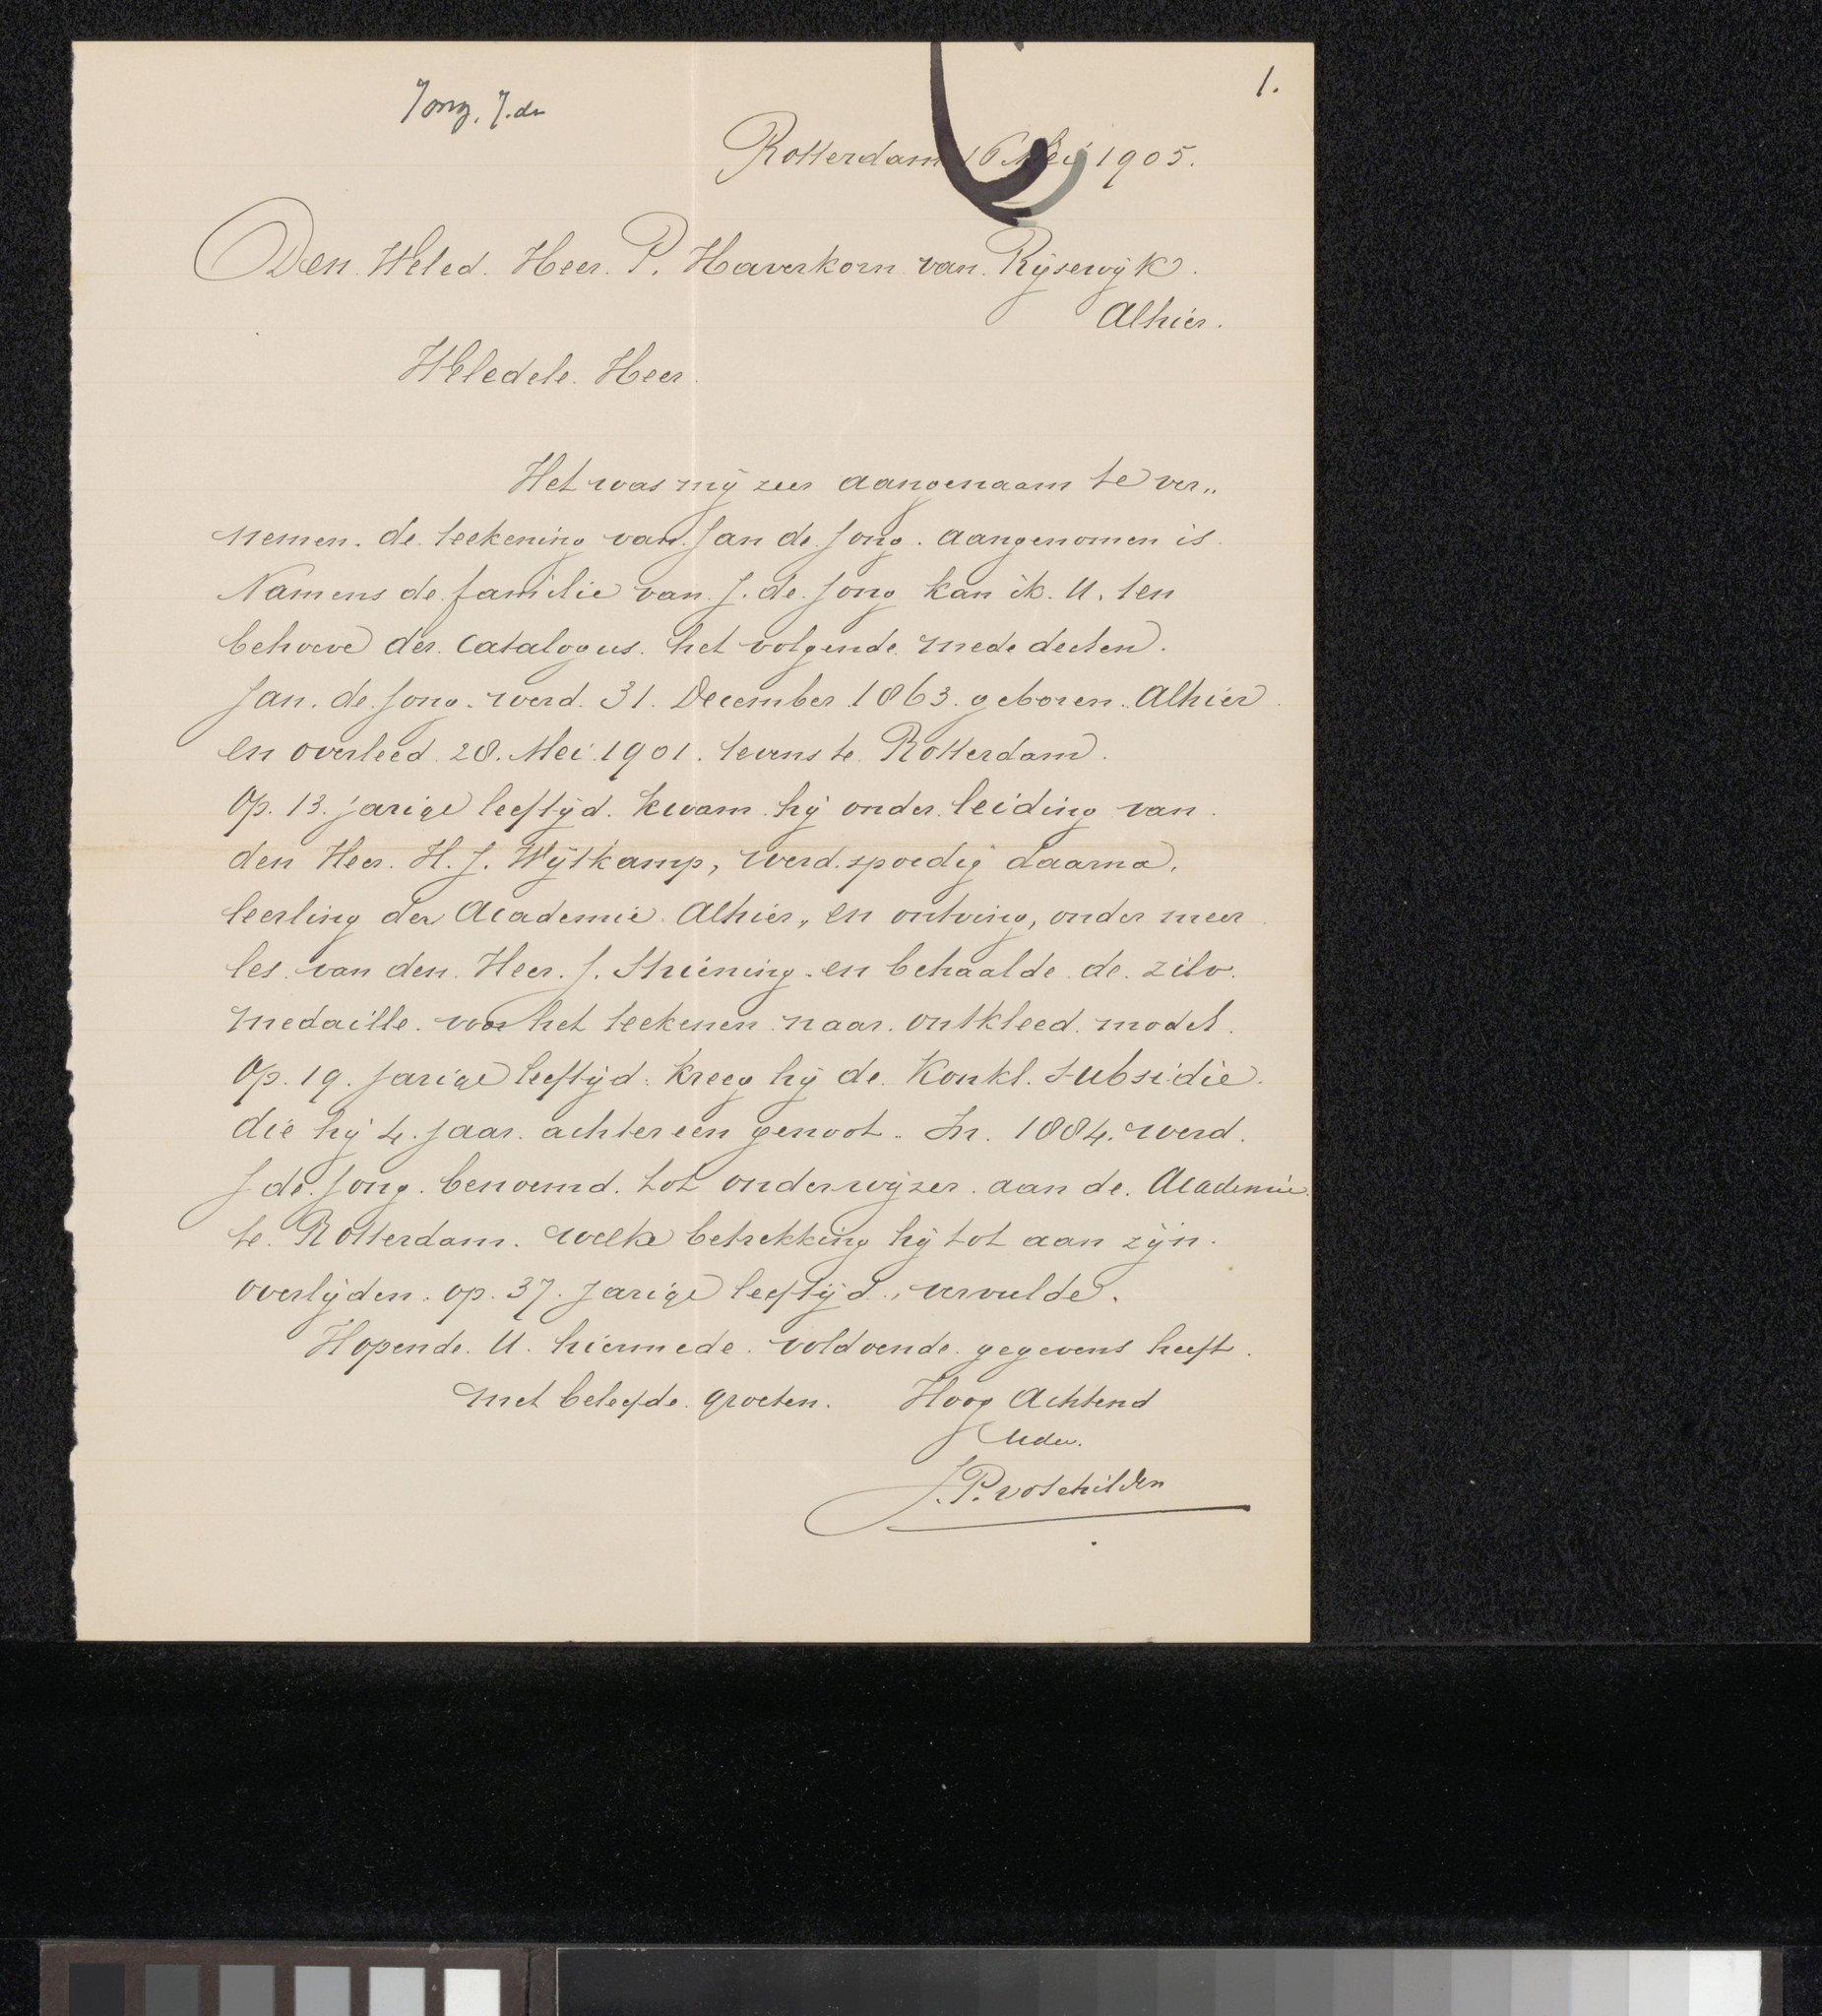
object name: letter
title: Brief aan Pieter Haverkorn van Rijsewijk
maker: johannes pieter van der schilden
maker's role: furniture worker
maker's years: 1851-1925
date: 1905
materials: ink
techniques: pen, writing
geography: rotterdam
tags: the hague, painter, draughtsman, jan de jong (1864-1901), haarlem, jan striening, pieter haverkorn van rijsewijk, drawing, distribution of awards ~ art contest, education, tuition of the artist (in general), money